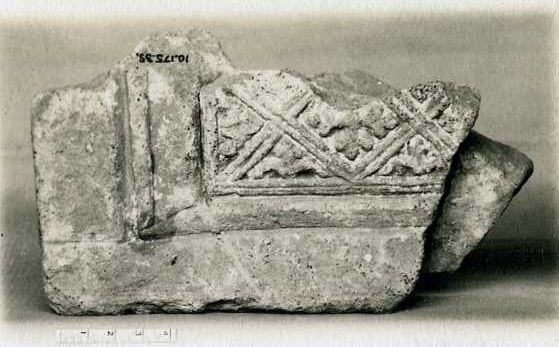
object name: fragment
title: Fragment of a Block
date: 501-700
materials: stone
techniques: carving, relief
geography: egypt